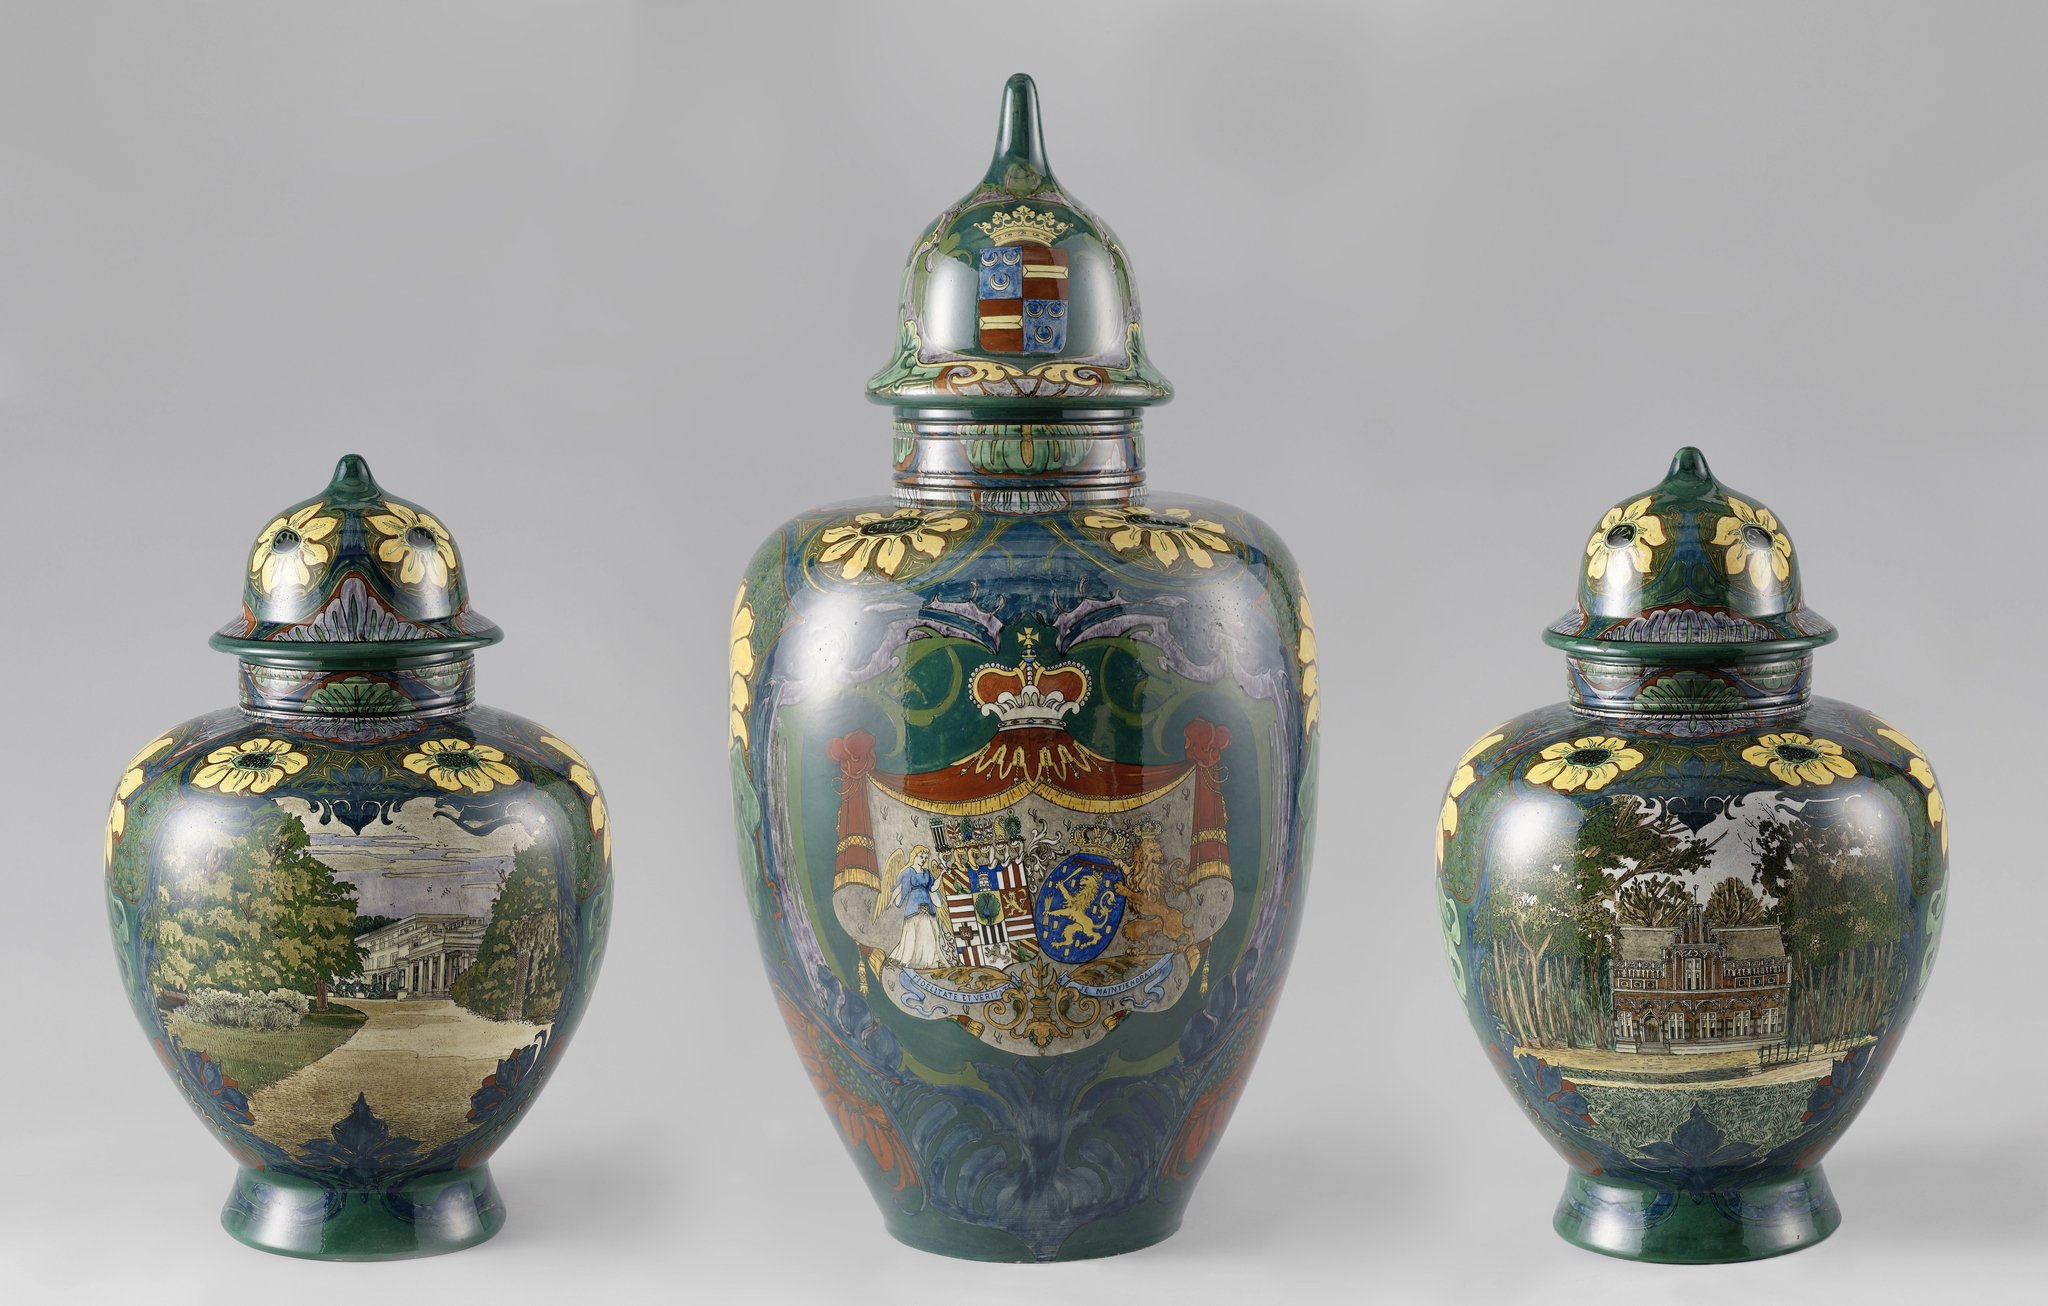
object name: vase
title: Drie vazen met deksels van aardewerk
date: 1896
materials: earthenware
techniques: painted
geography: the hague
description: Groep van drie vazen met deksels van aardewerk, polychroom beschilderd met zonnebloemen, wapens en topografische voorstellingen. Tussen en boven de voorstellingen zijn zonnebloemen geschilderd.